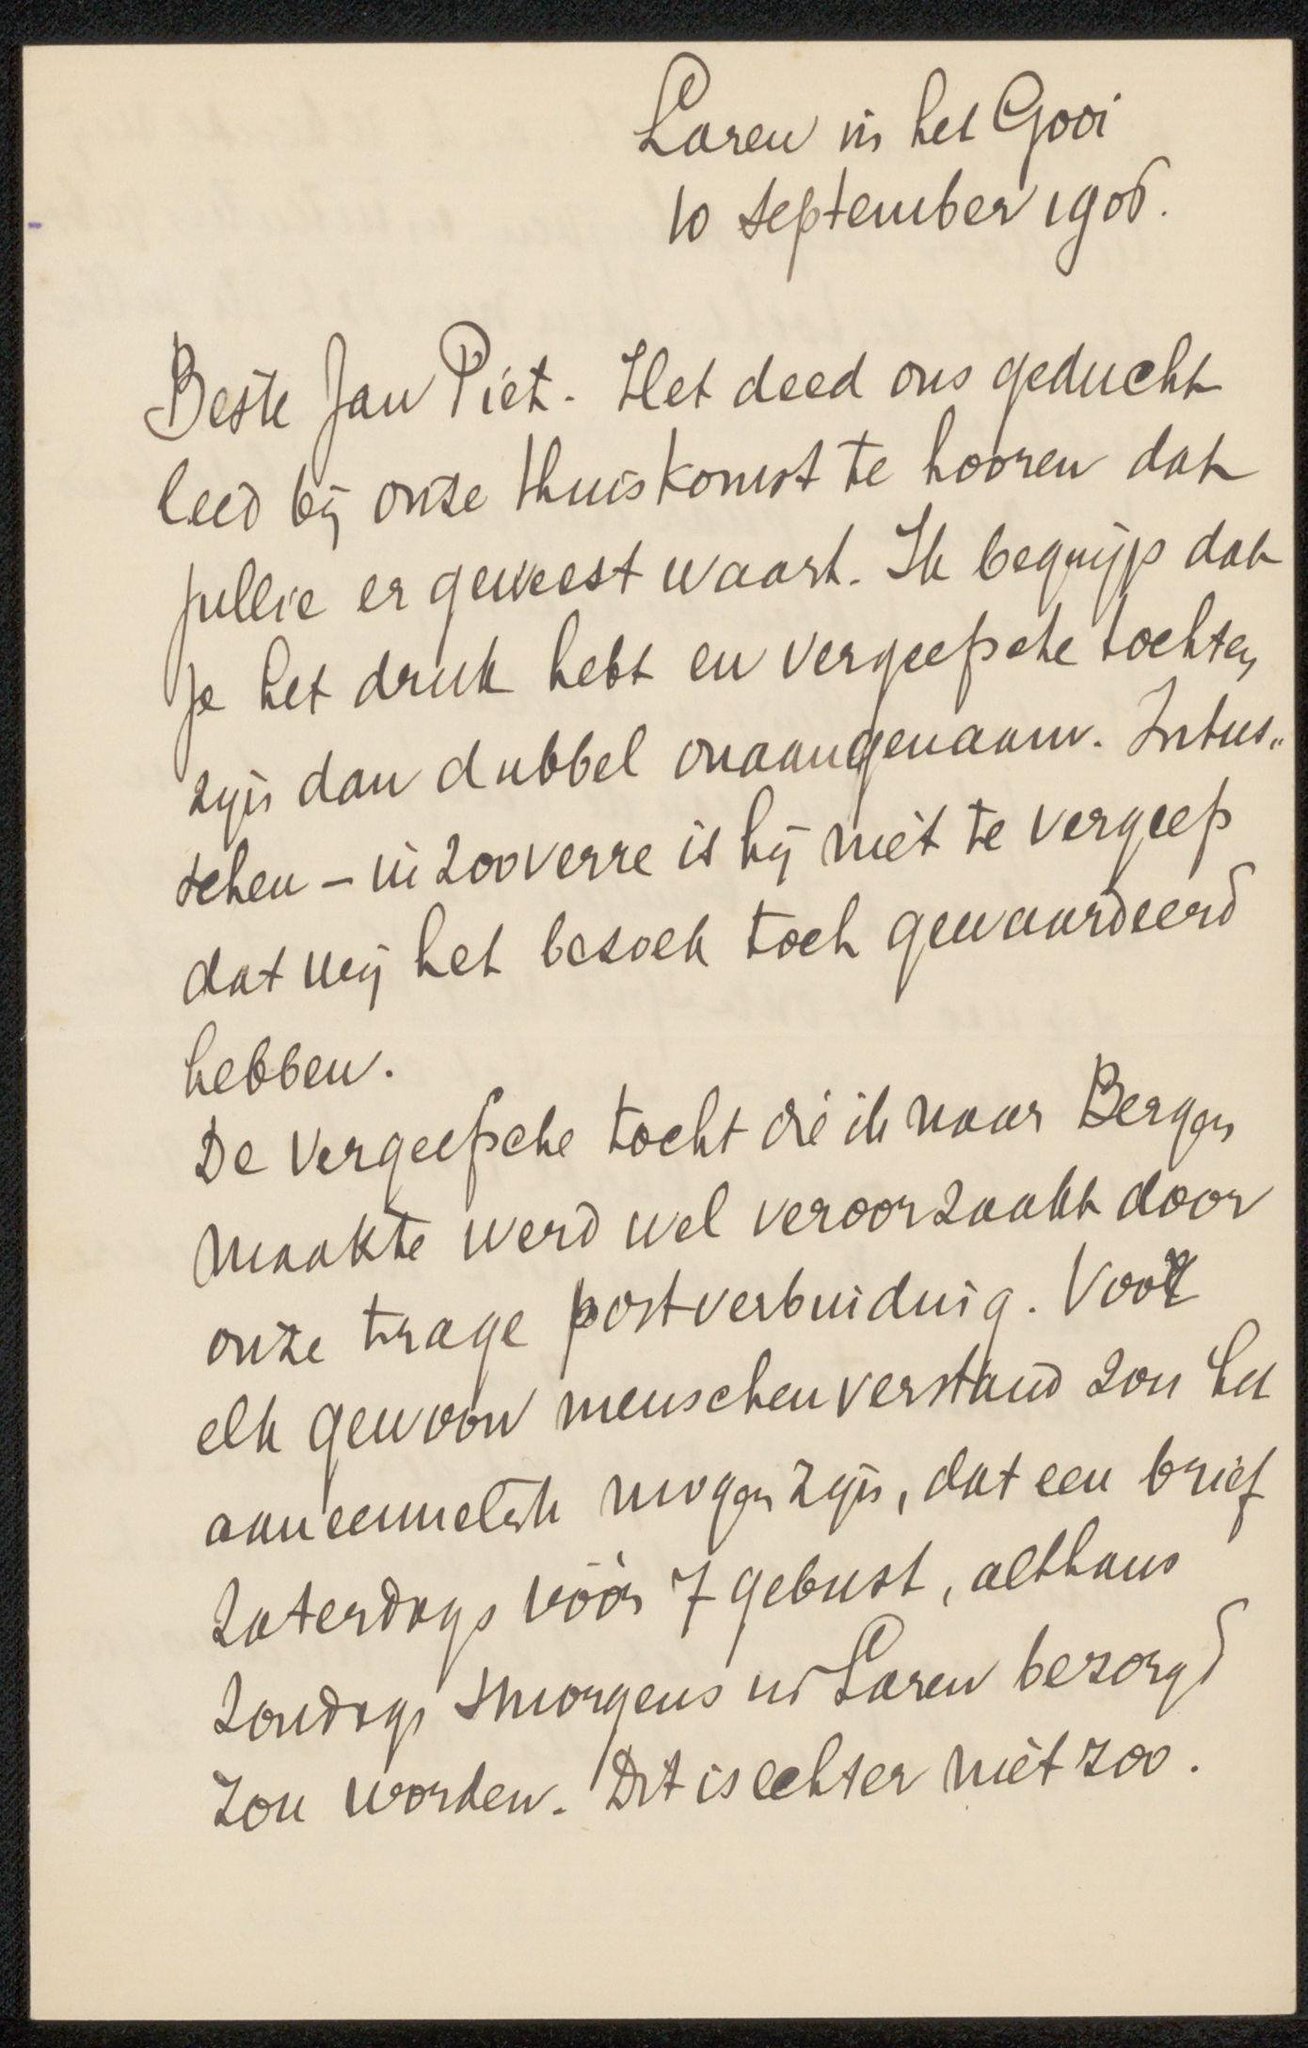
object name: letter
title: Brief aan Jan Veth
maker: antoon derkinderen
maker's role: draughtsman, painter, print maker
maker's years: 1859-1925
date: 1906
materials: ink, paper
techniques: pen, writing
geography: laren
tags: designer, jan veth, amsterdam, albert verwey, applied arts, arts and crafts; industrial design, exhibition ~ art, leiden, gelderland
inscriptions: collector's mark: ‘RPK’